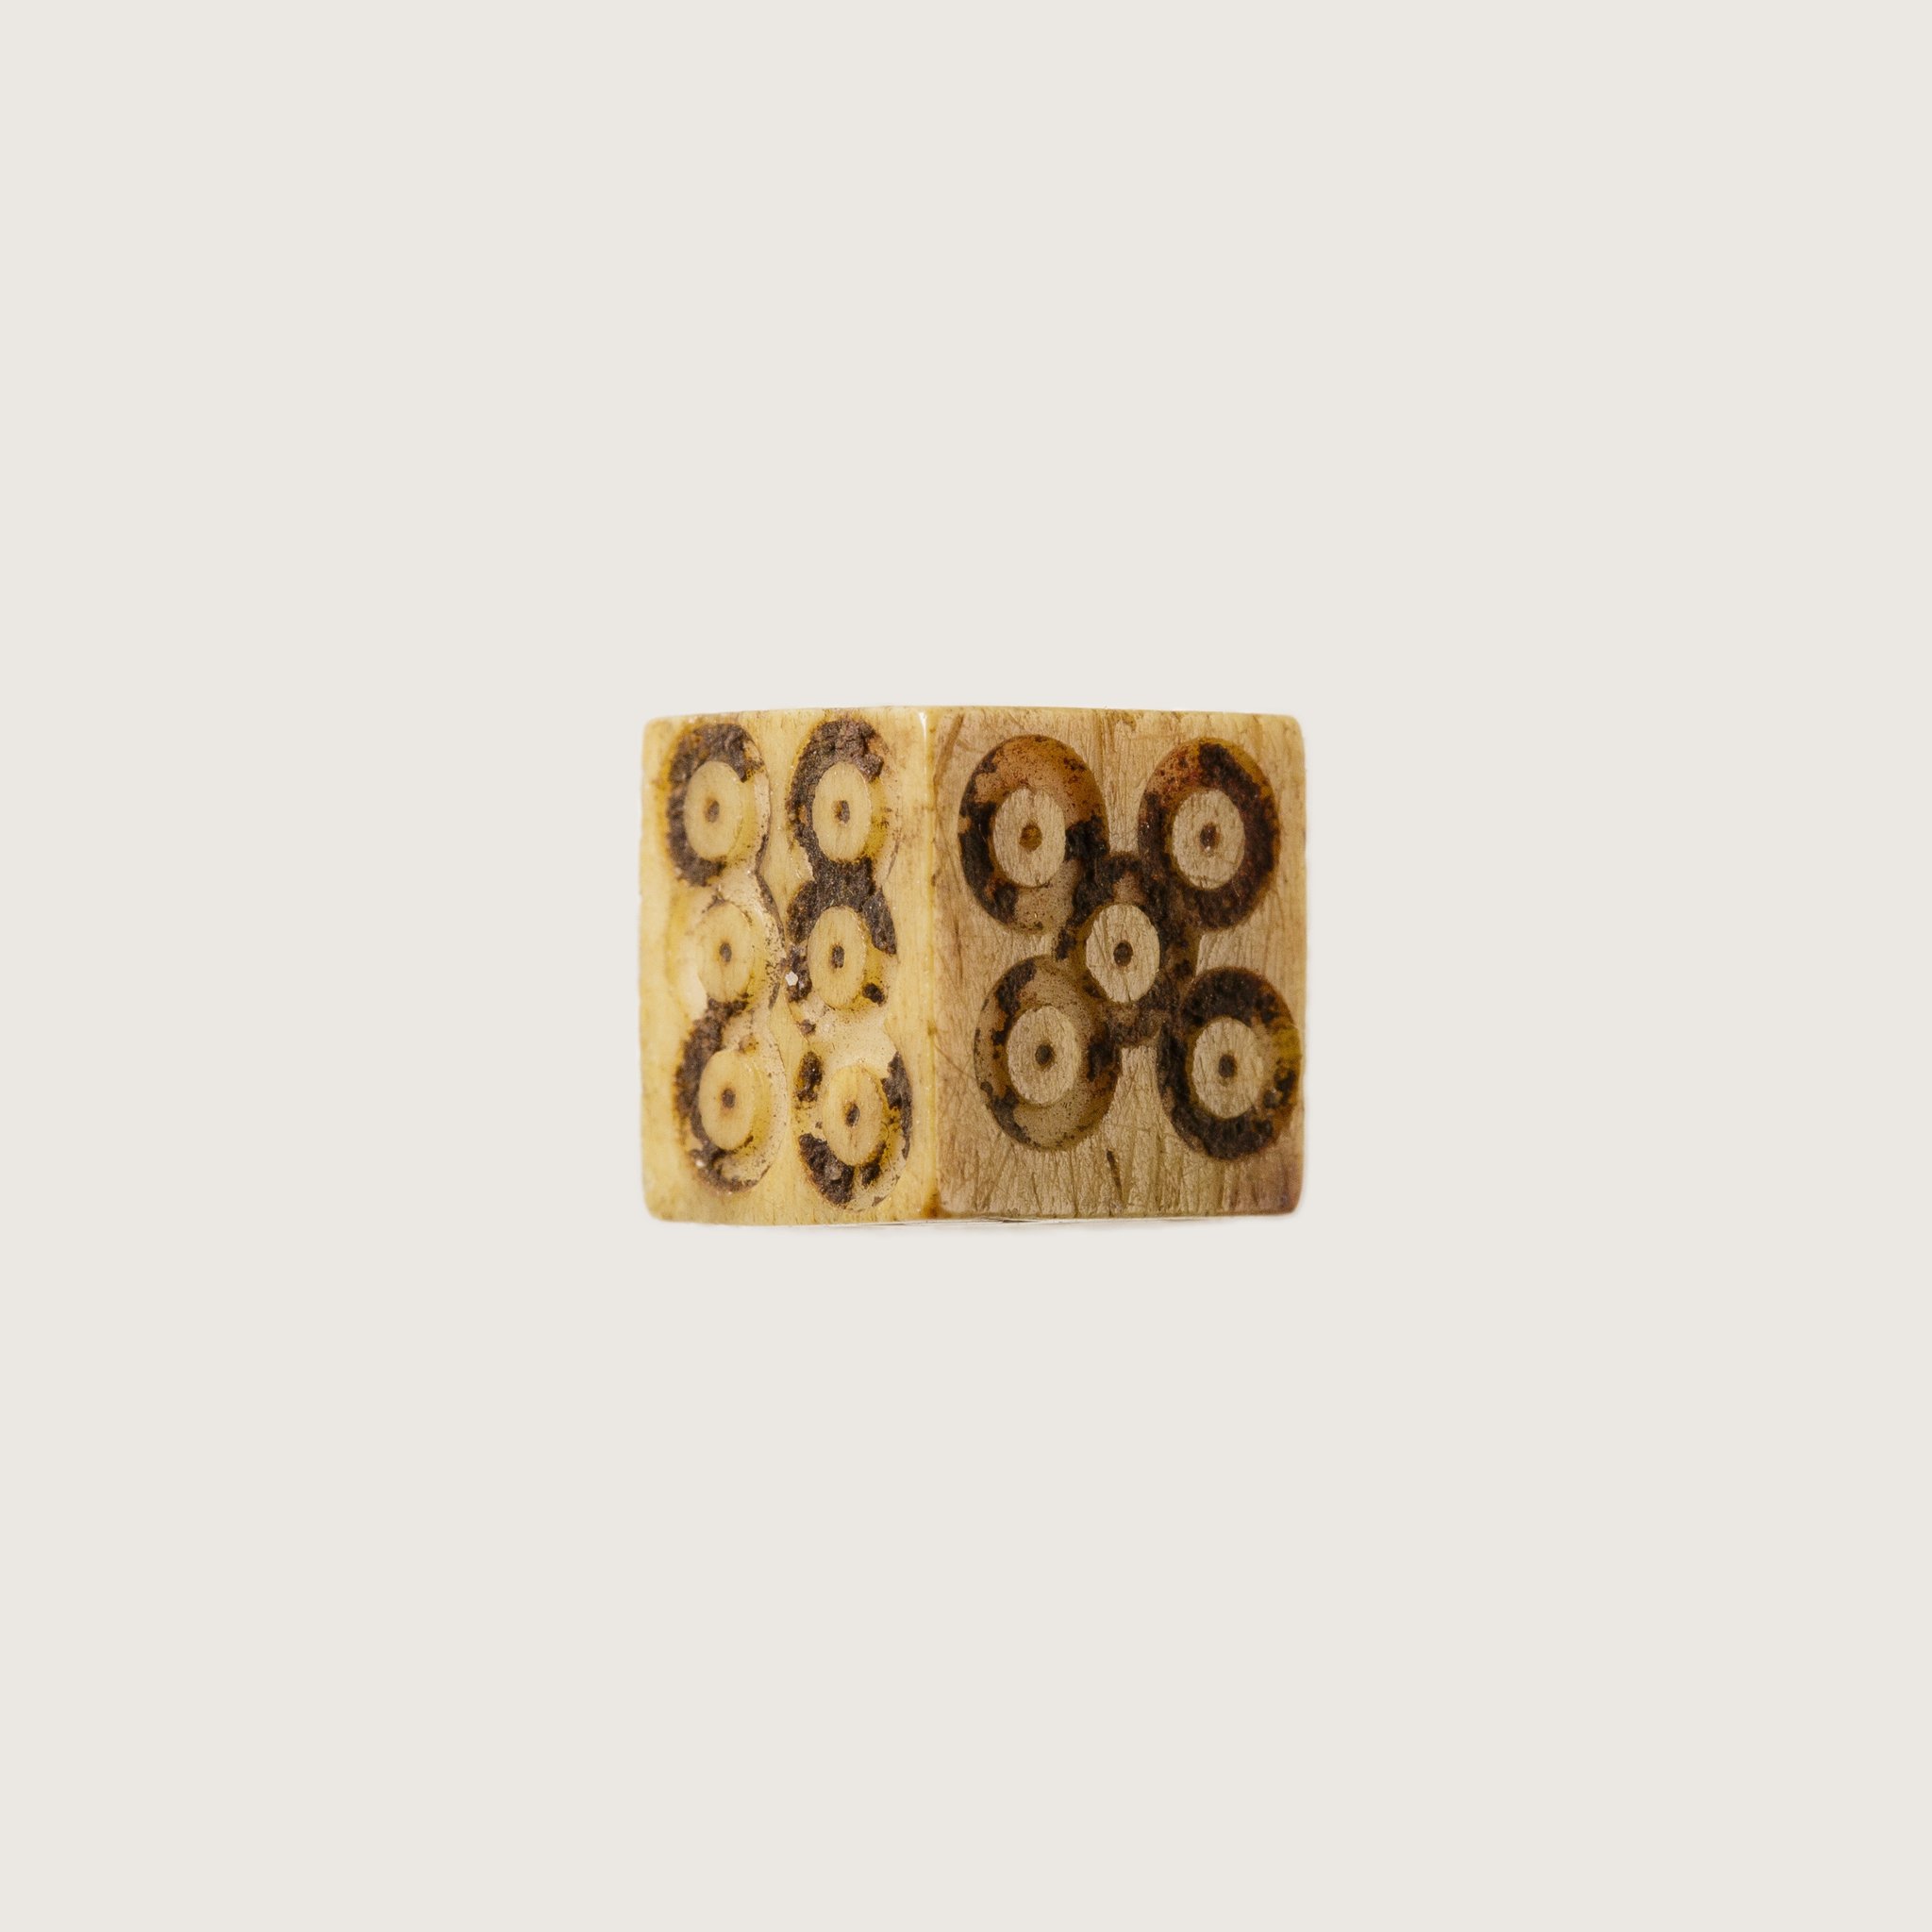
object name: dice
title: Die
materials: ivory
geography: egypt